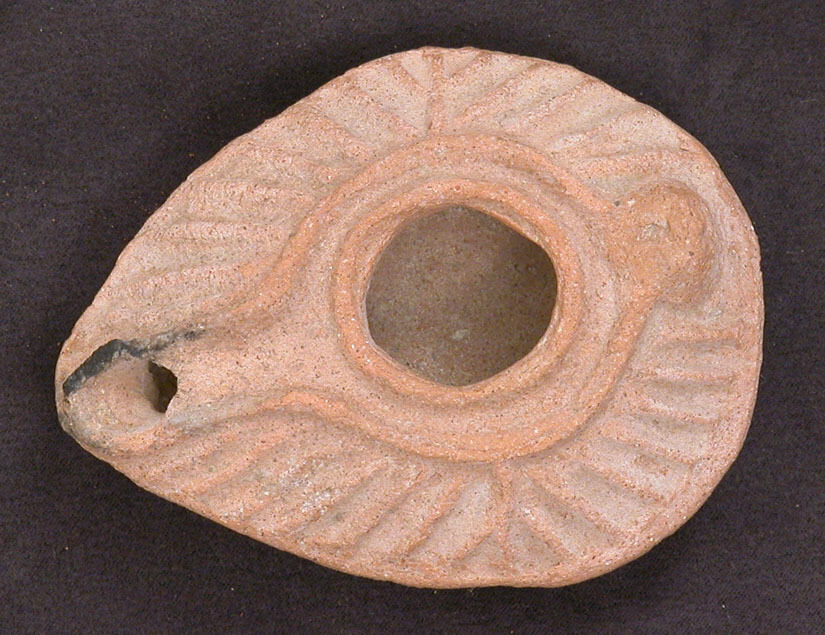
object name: lamp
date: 401-700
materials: earthenware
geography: palestine